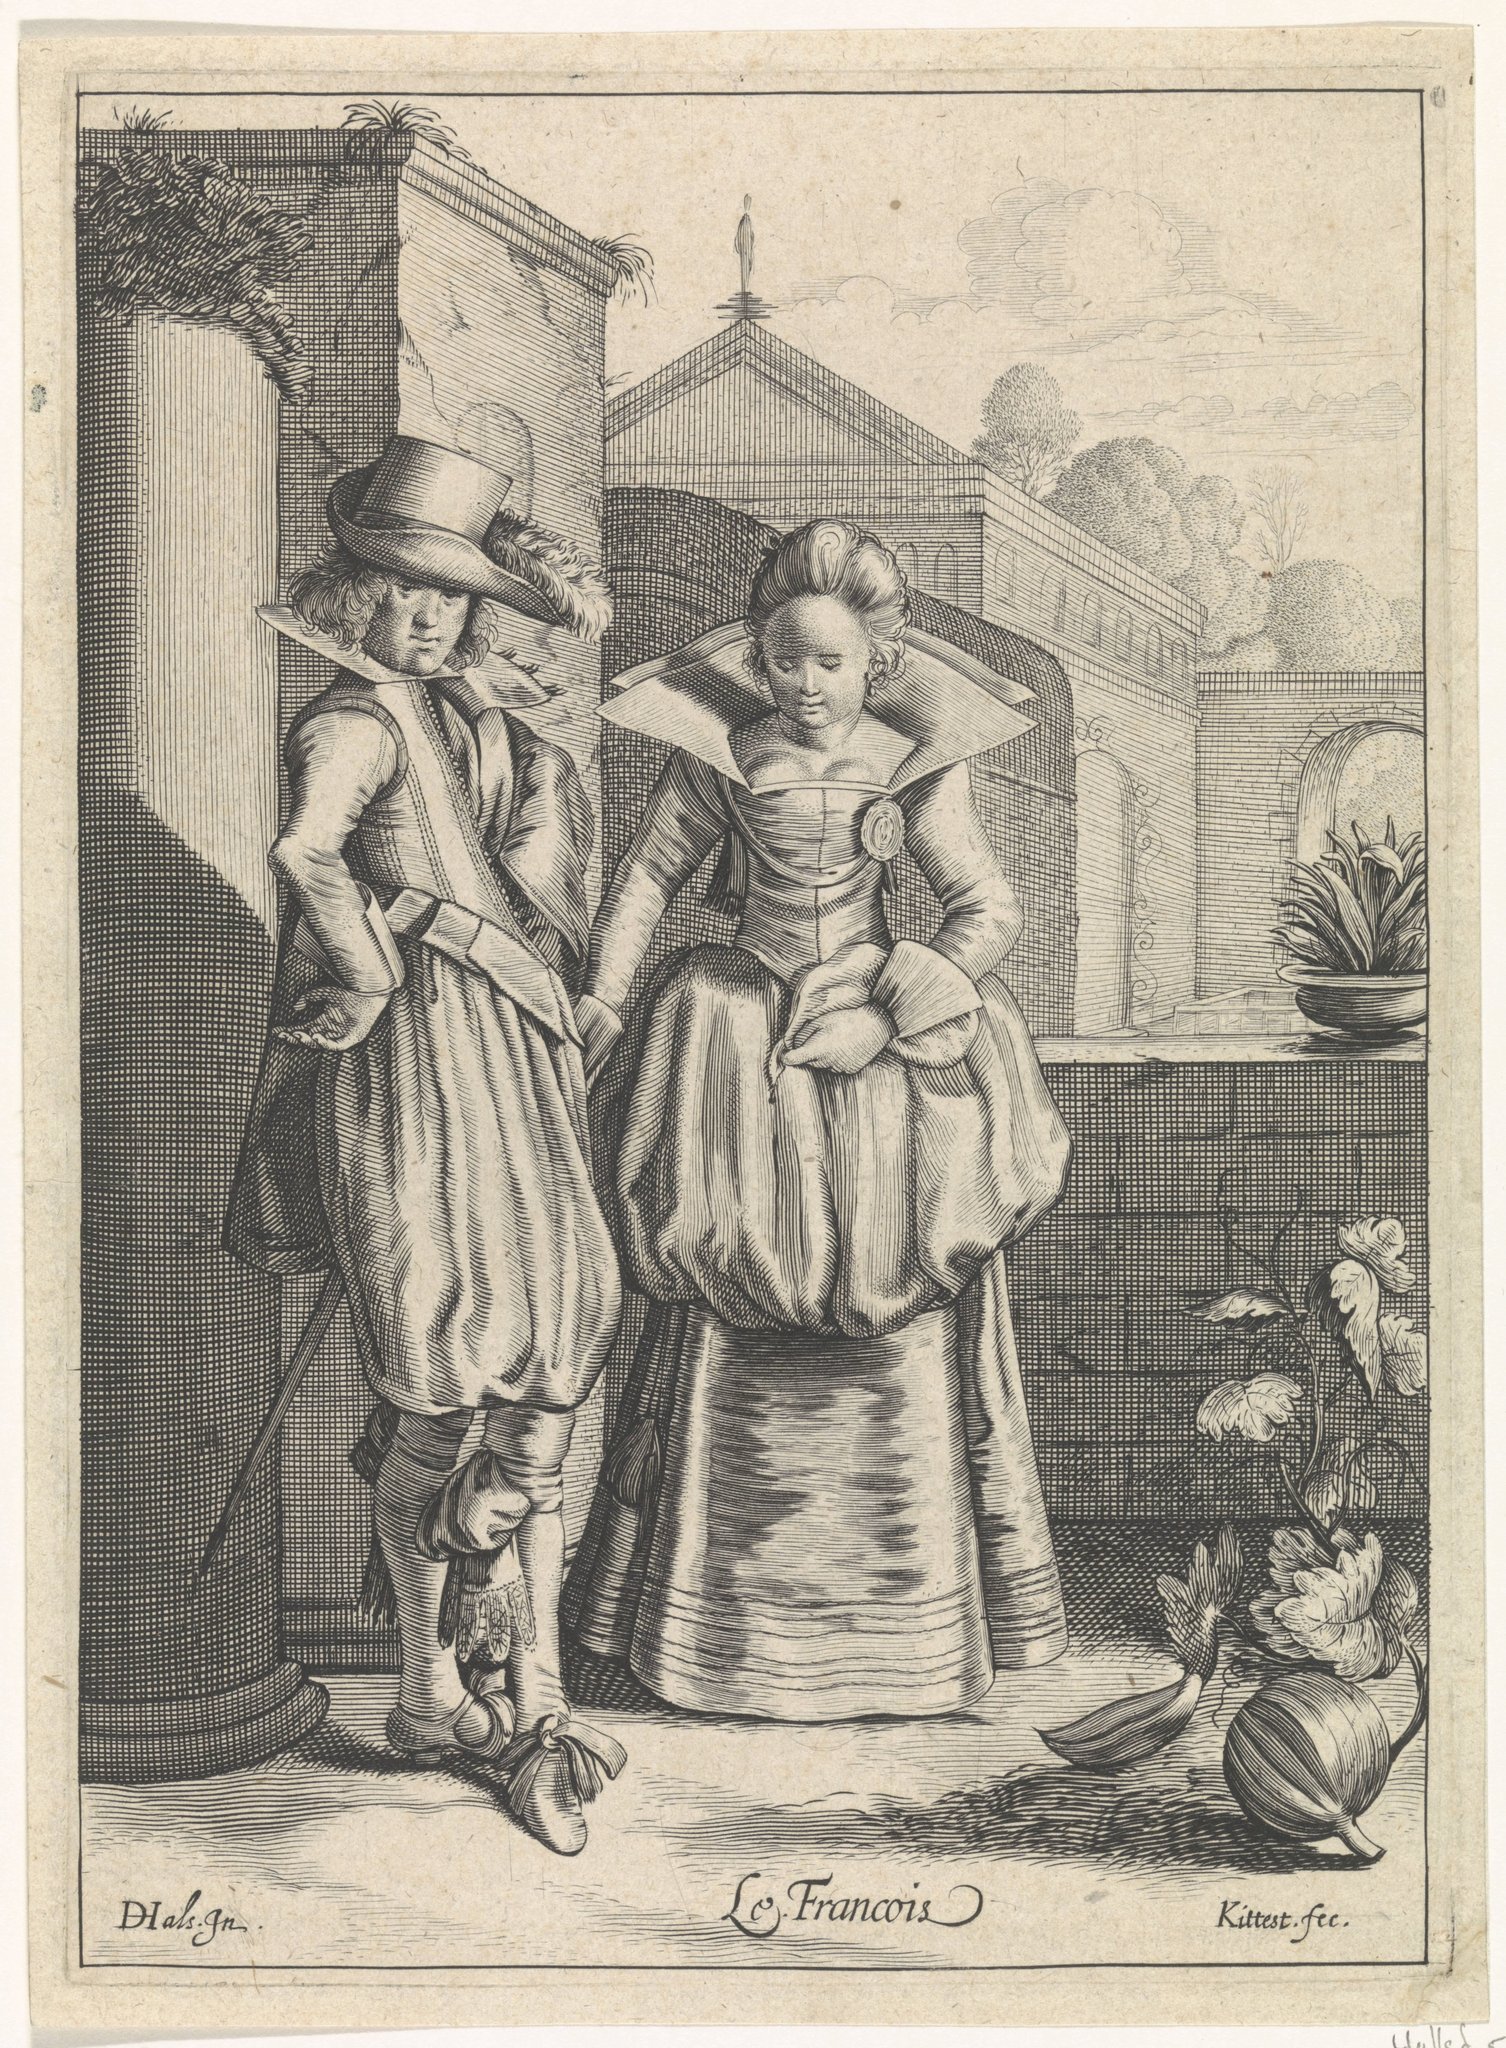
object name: costume print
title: Kostuums in Europa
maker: cornelis van kittensteyn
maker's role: print maker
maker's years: 1597-1663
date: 1615-1625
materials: paper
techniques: engraving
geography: netherlands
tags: brooch, agraffe, clasp (+ women's clothes), bow (ornamental part of clothing) (+ men's clothes), head-gear: hat (+ men's clothes), neck-gear: collar (+ women's clothes), clothes, costume (+ women's clothes), skirt (+ women's clothes), sleeves: cuffs (+ women's clothes), dress, gown (+ women's clothes), europeans (with name), shoes, sandals (+ men's clothes), clothes, costume (+ men's clothes), folk costume, regional costume, plants and herbs, neck-gear: collar (+ men's clothes), trousers, breeches, etc. (breeches) (+ men's clothes), clothing for the upper part of the body (doublet) (+ men's clothes), sleeves (+ women's clothes), head-gear: hat (+ feathers used for clothes), clothing for the upper part of the body (with name) (+ women's clothes), france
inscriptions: collector's mark: Lugt 2760, collector's mark: Lugt 2228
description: Kleding man: hoed met brede opgeslagen rand en veer; wambuis met puntvormige schootpanden, kleine schouderrol; pofbroek tot op de knie met gestrikte kniebanden. Schoenen met striksluiting. Kleding vrouw: dubbele hoog opstaande kraag, sluitend aan vierkante halsuitsnijding waarop links een rozet. Kleine oorbel. Opgeschorte overrok. Zakdoek in de hand.